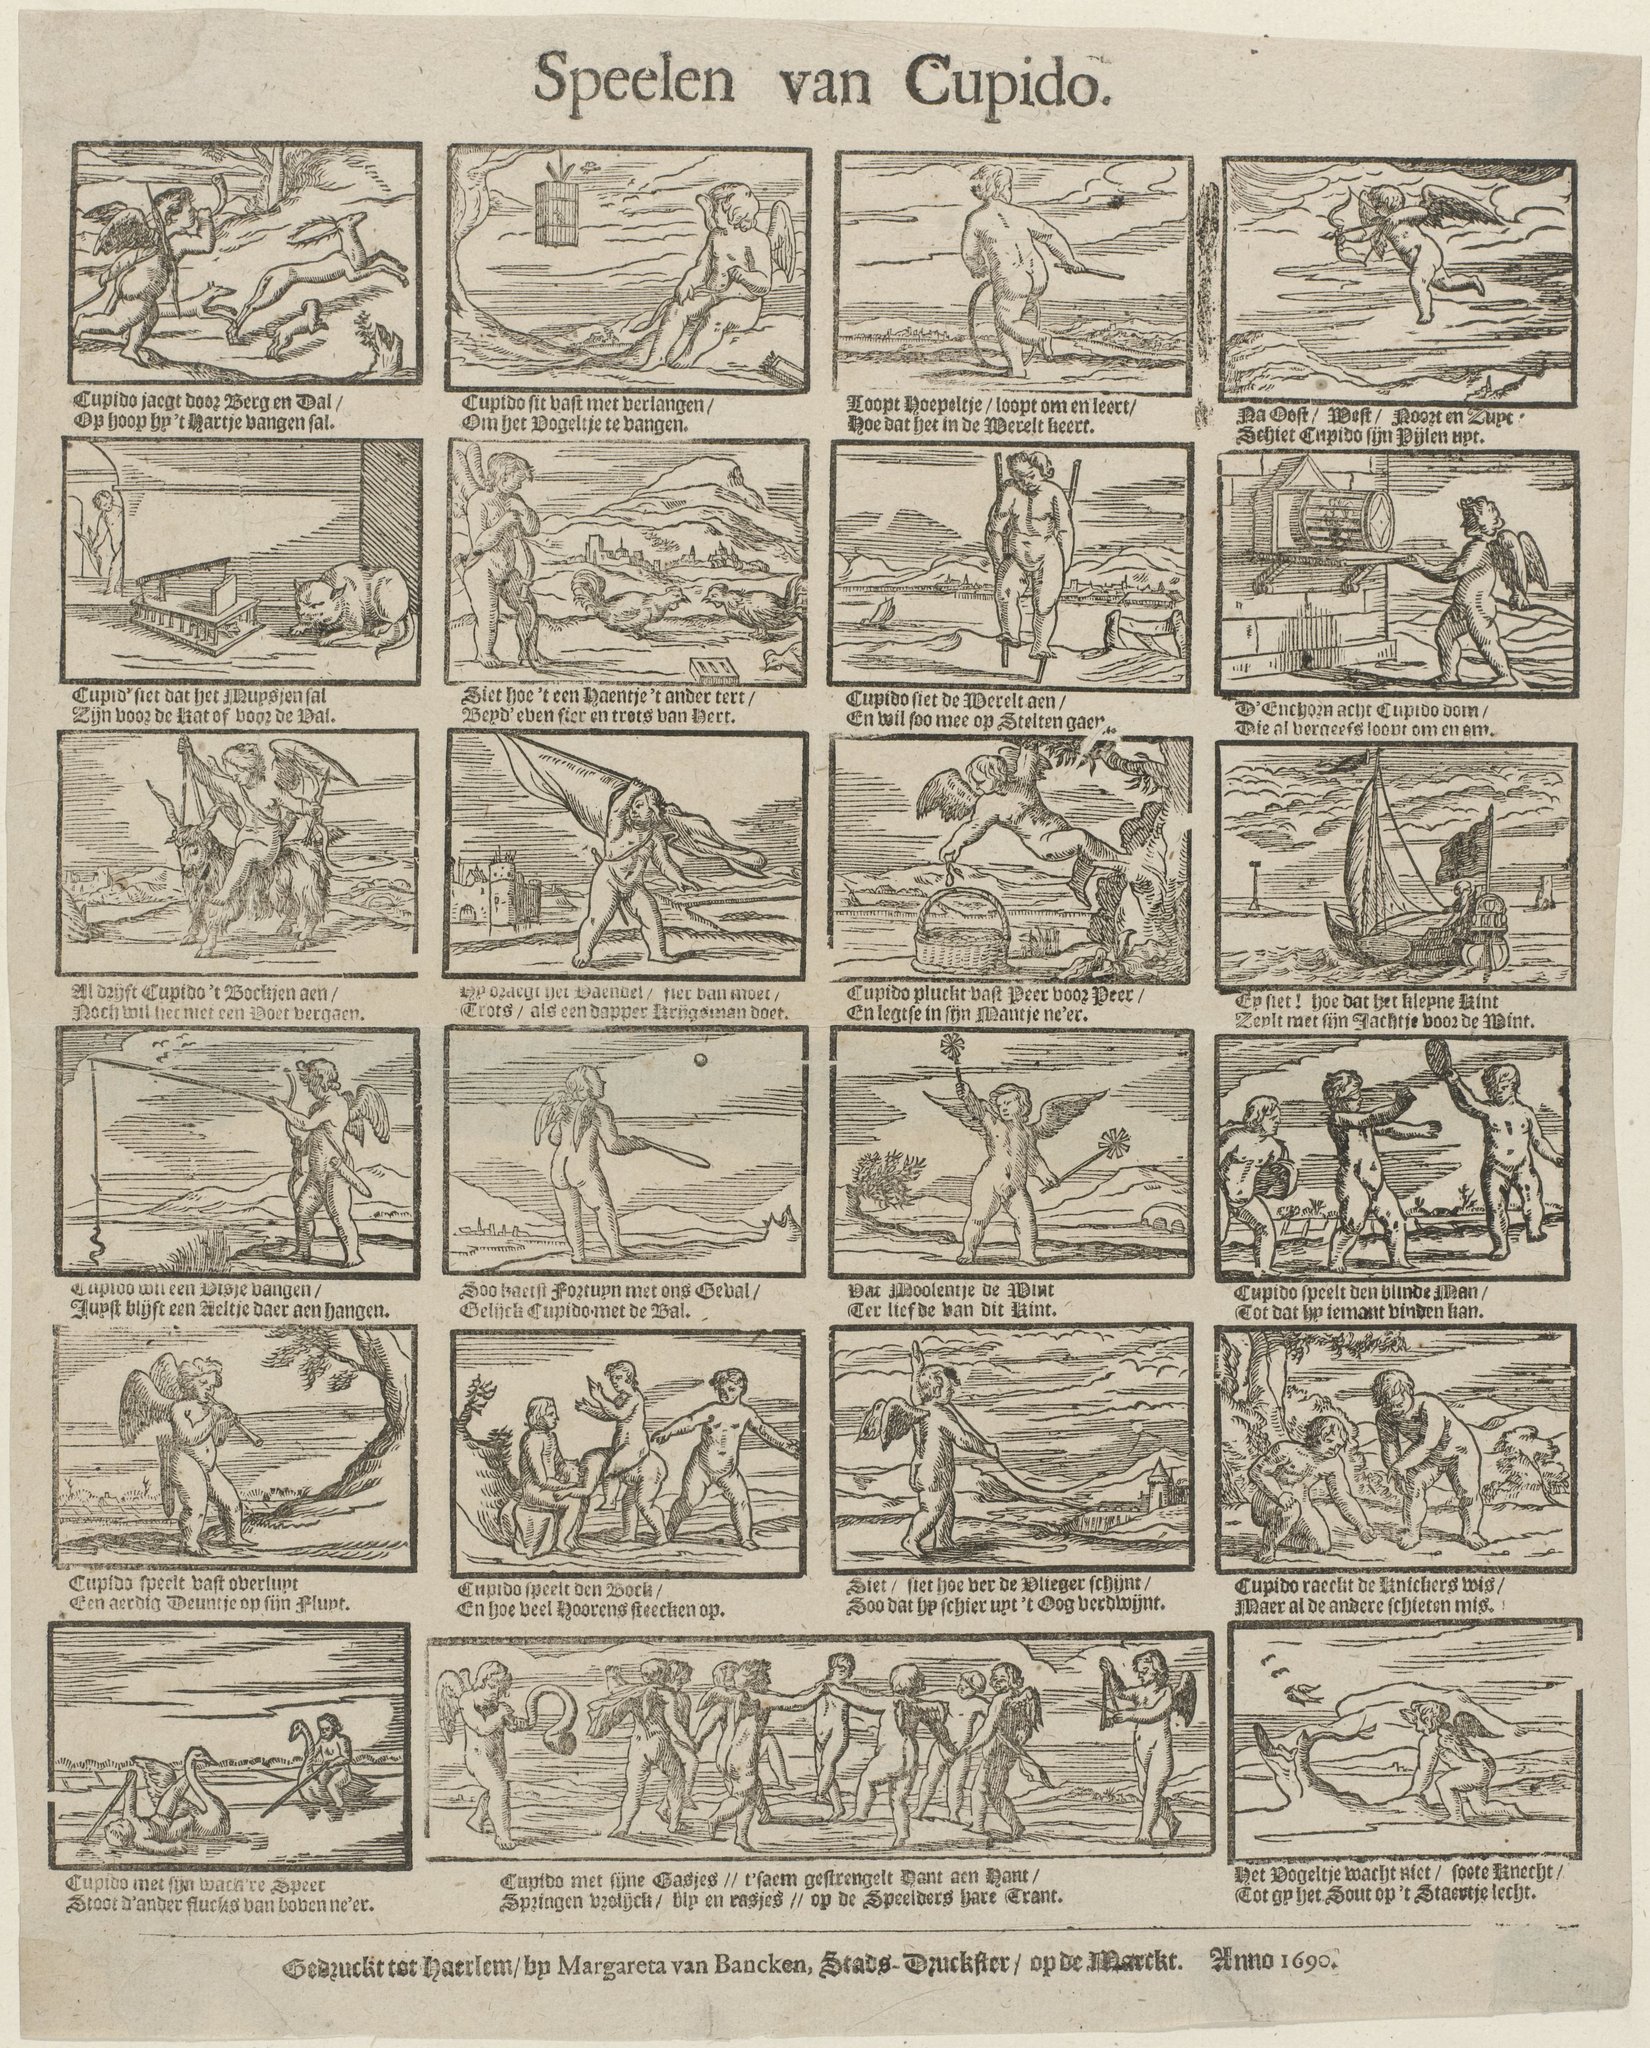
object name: popular print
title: Speelen van Cupido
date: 1690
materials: paper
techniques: letterpress printing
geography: haarlem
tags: games using special objects (marbles, top, hoop, etc.), cupids: 'amores', 'amoretti', 'putti'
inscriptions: date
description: Blad met 24 voorstellingen van kinderspelen en bezigheden voorgesteld met Cupido's, zoals knikkeren, hoepelen en vissen. Onder elke afbeelding een tweeregelig vers.